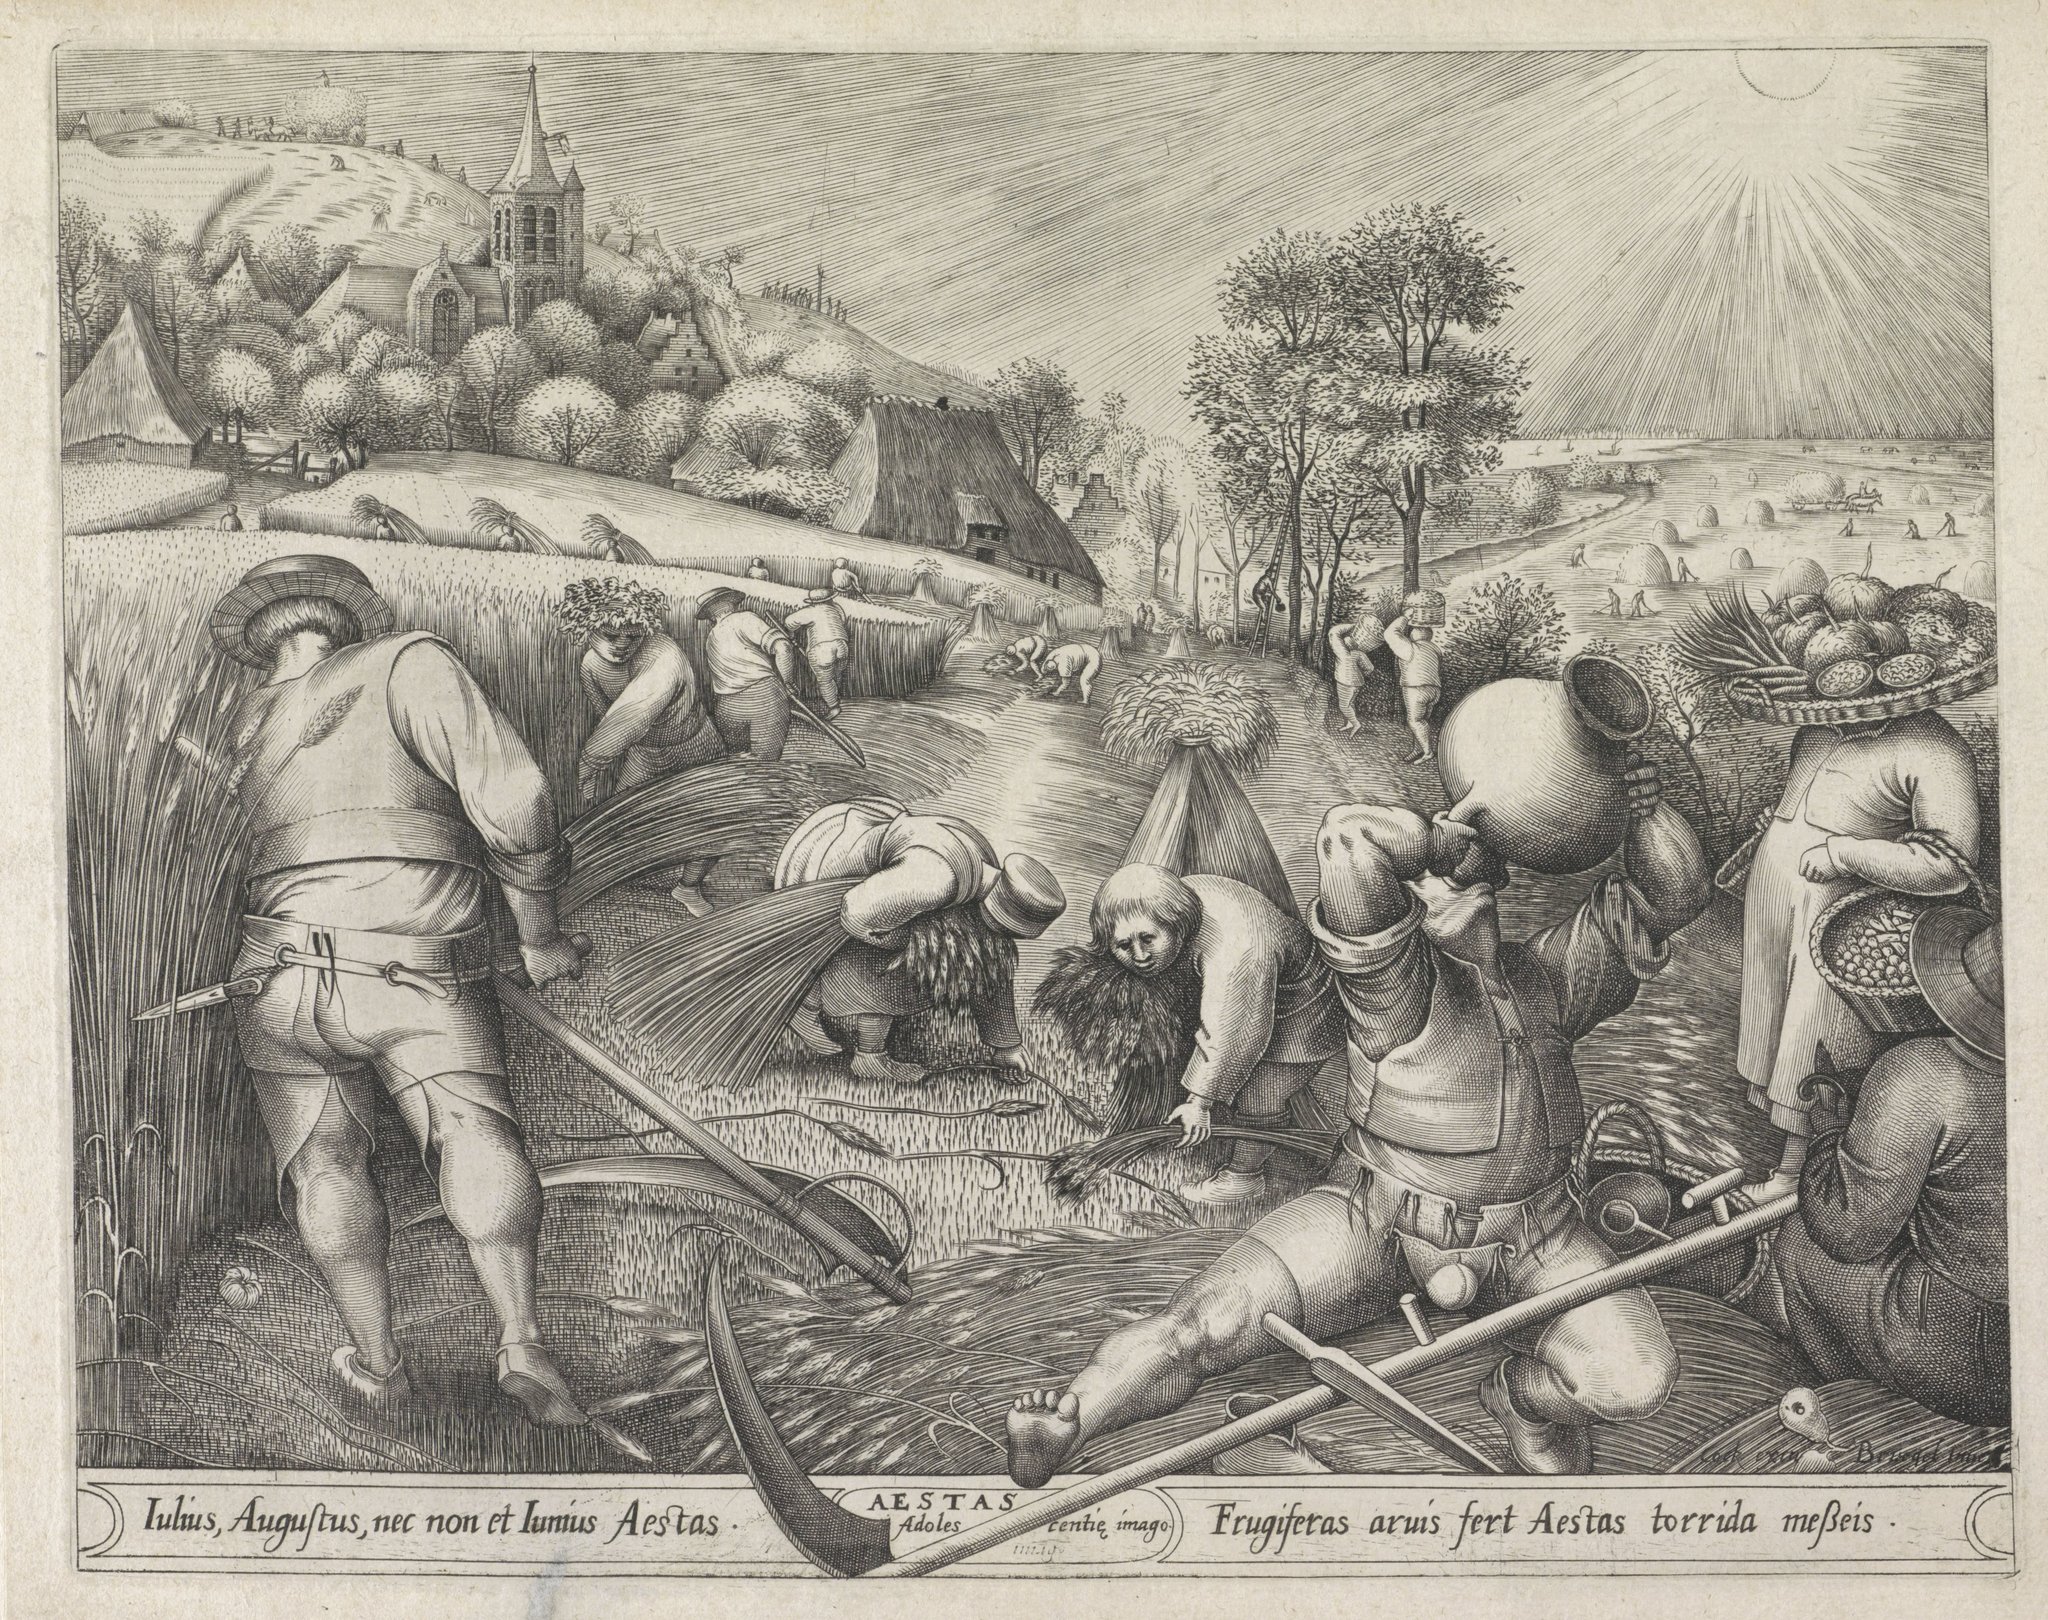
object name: print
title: De vier seizoenen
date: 1570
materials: paper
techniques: engraving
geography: antwerp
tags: harvest, summer ~ human activities (the four seasons of the year), rest during harvest (eating, dancing, making love, etc.)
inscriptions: title: ‘AESTAS’, signature: ‘Bruegel inve.’, caption: ‘Iulius, Augustus, nec non Iunius Aestas / Frugiferas arvis fert Aestas torrida messeis’, collector's mark: Lugt 2228, address: ‘Cock excu.’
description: Het seizoen zomer: de maanden juni, juli en augustus. De bezigheden behorend bij de zomer: graanoogst, snijden van het graan met de zeis, rapen van aren en binden tot schoven. Rechts op de voorgrond het rusten, eten en drinken tijdens de oogst. Onder de voorstelling een tekst in het Latijn.